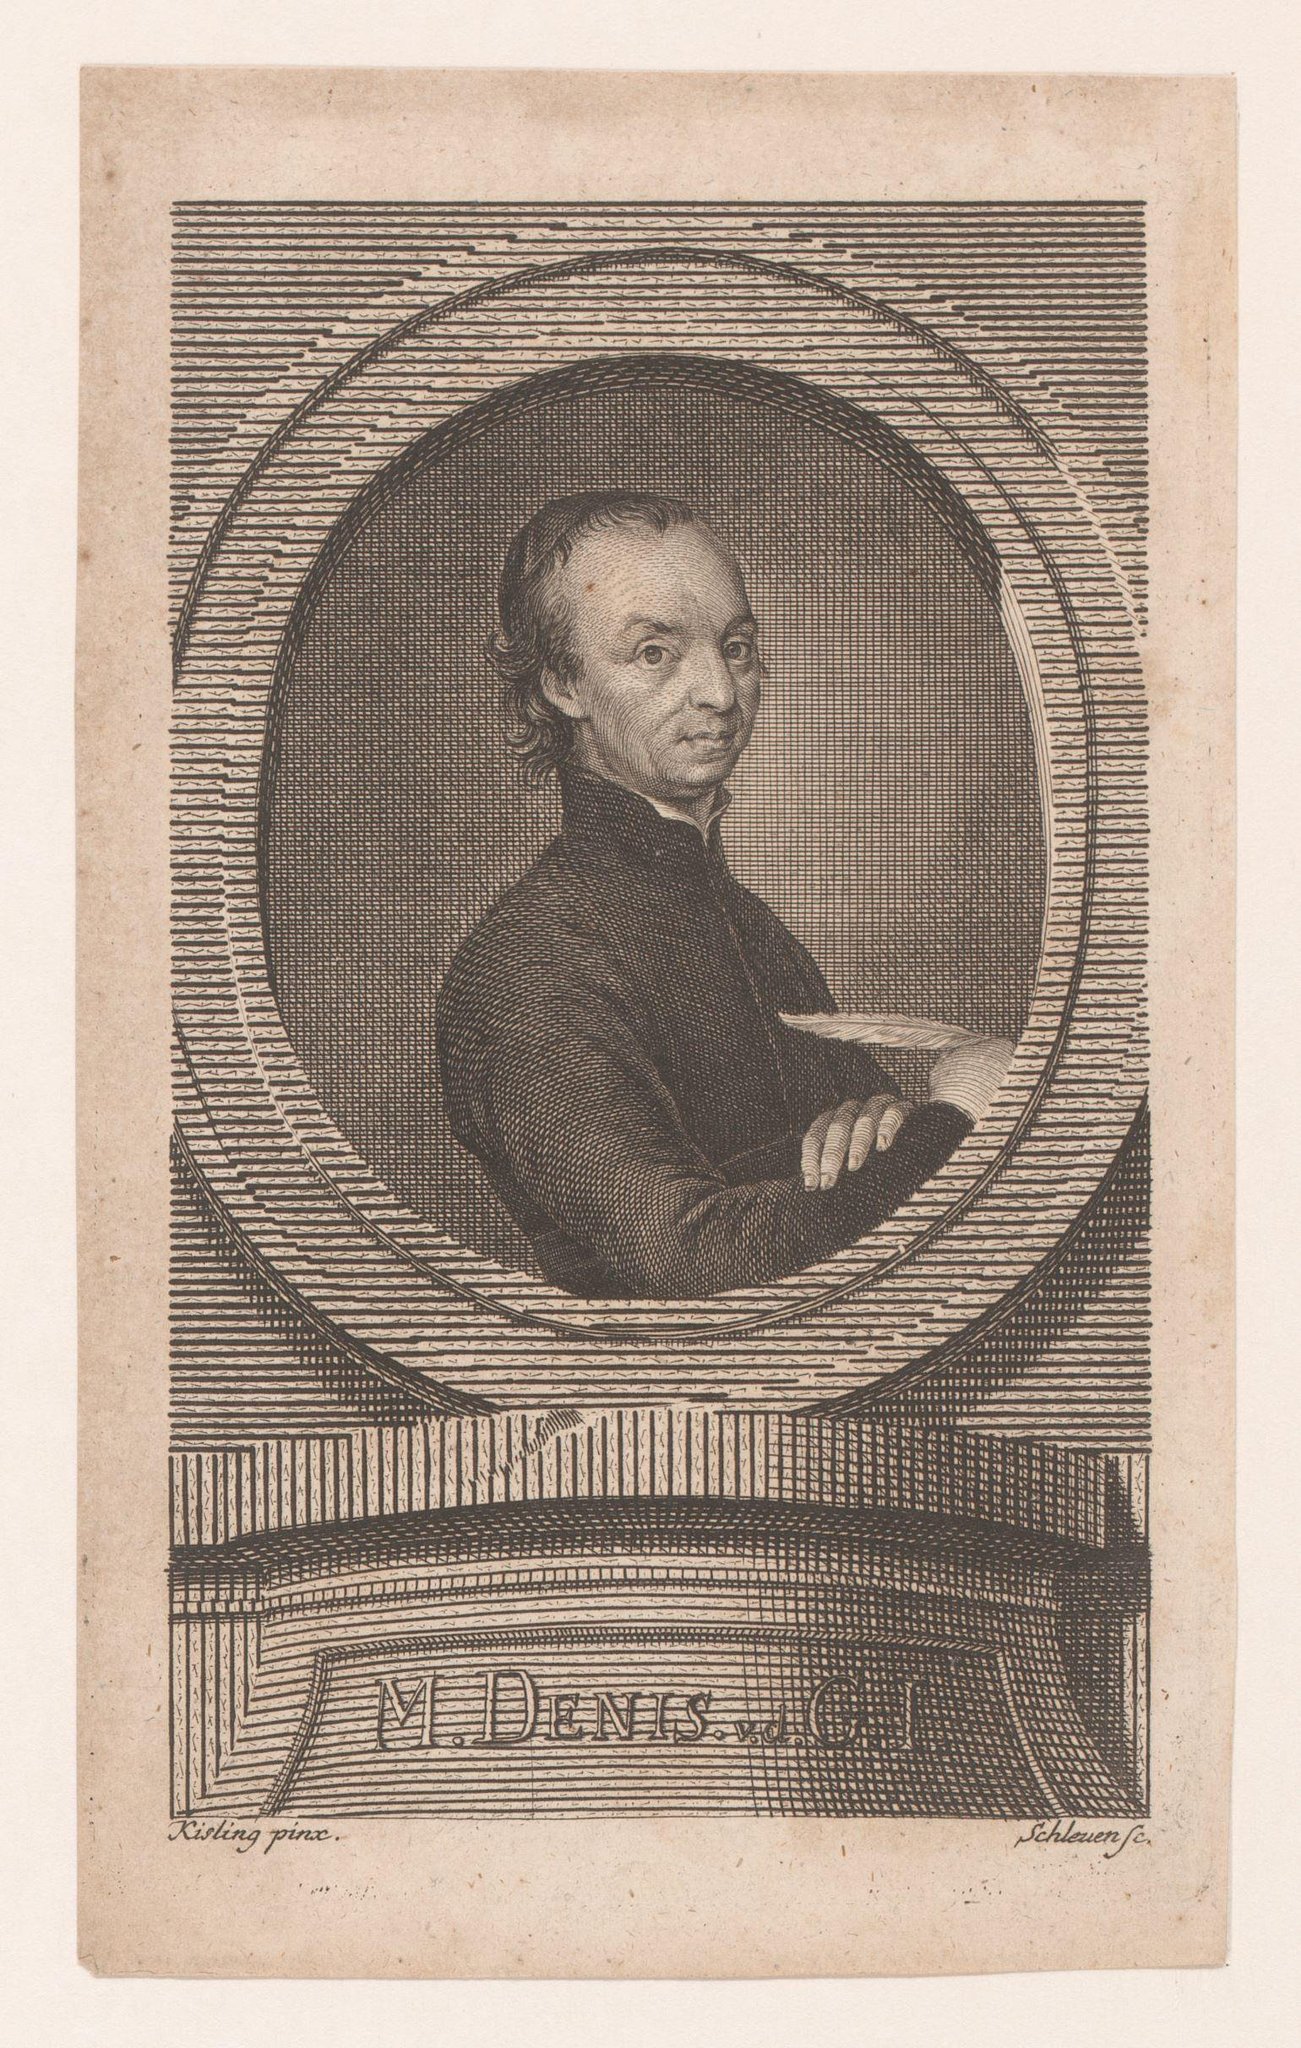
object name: print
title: Portret van Michael Denis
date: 1721-1771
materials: paper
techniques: engraving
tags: priest, historical persons, portrait of a writer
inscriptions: collector's mark: Lugt 2228